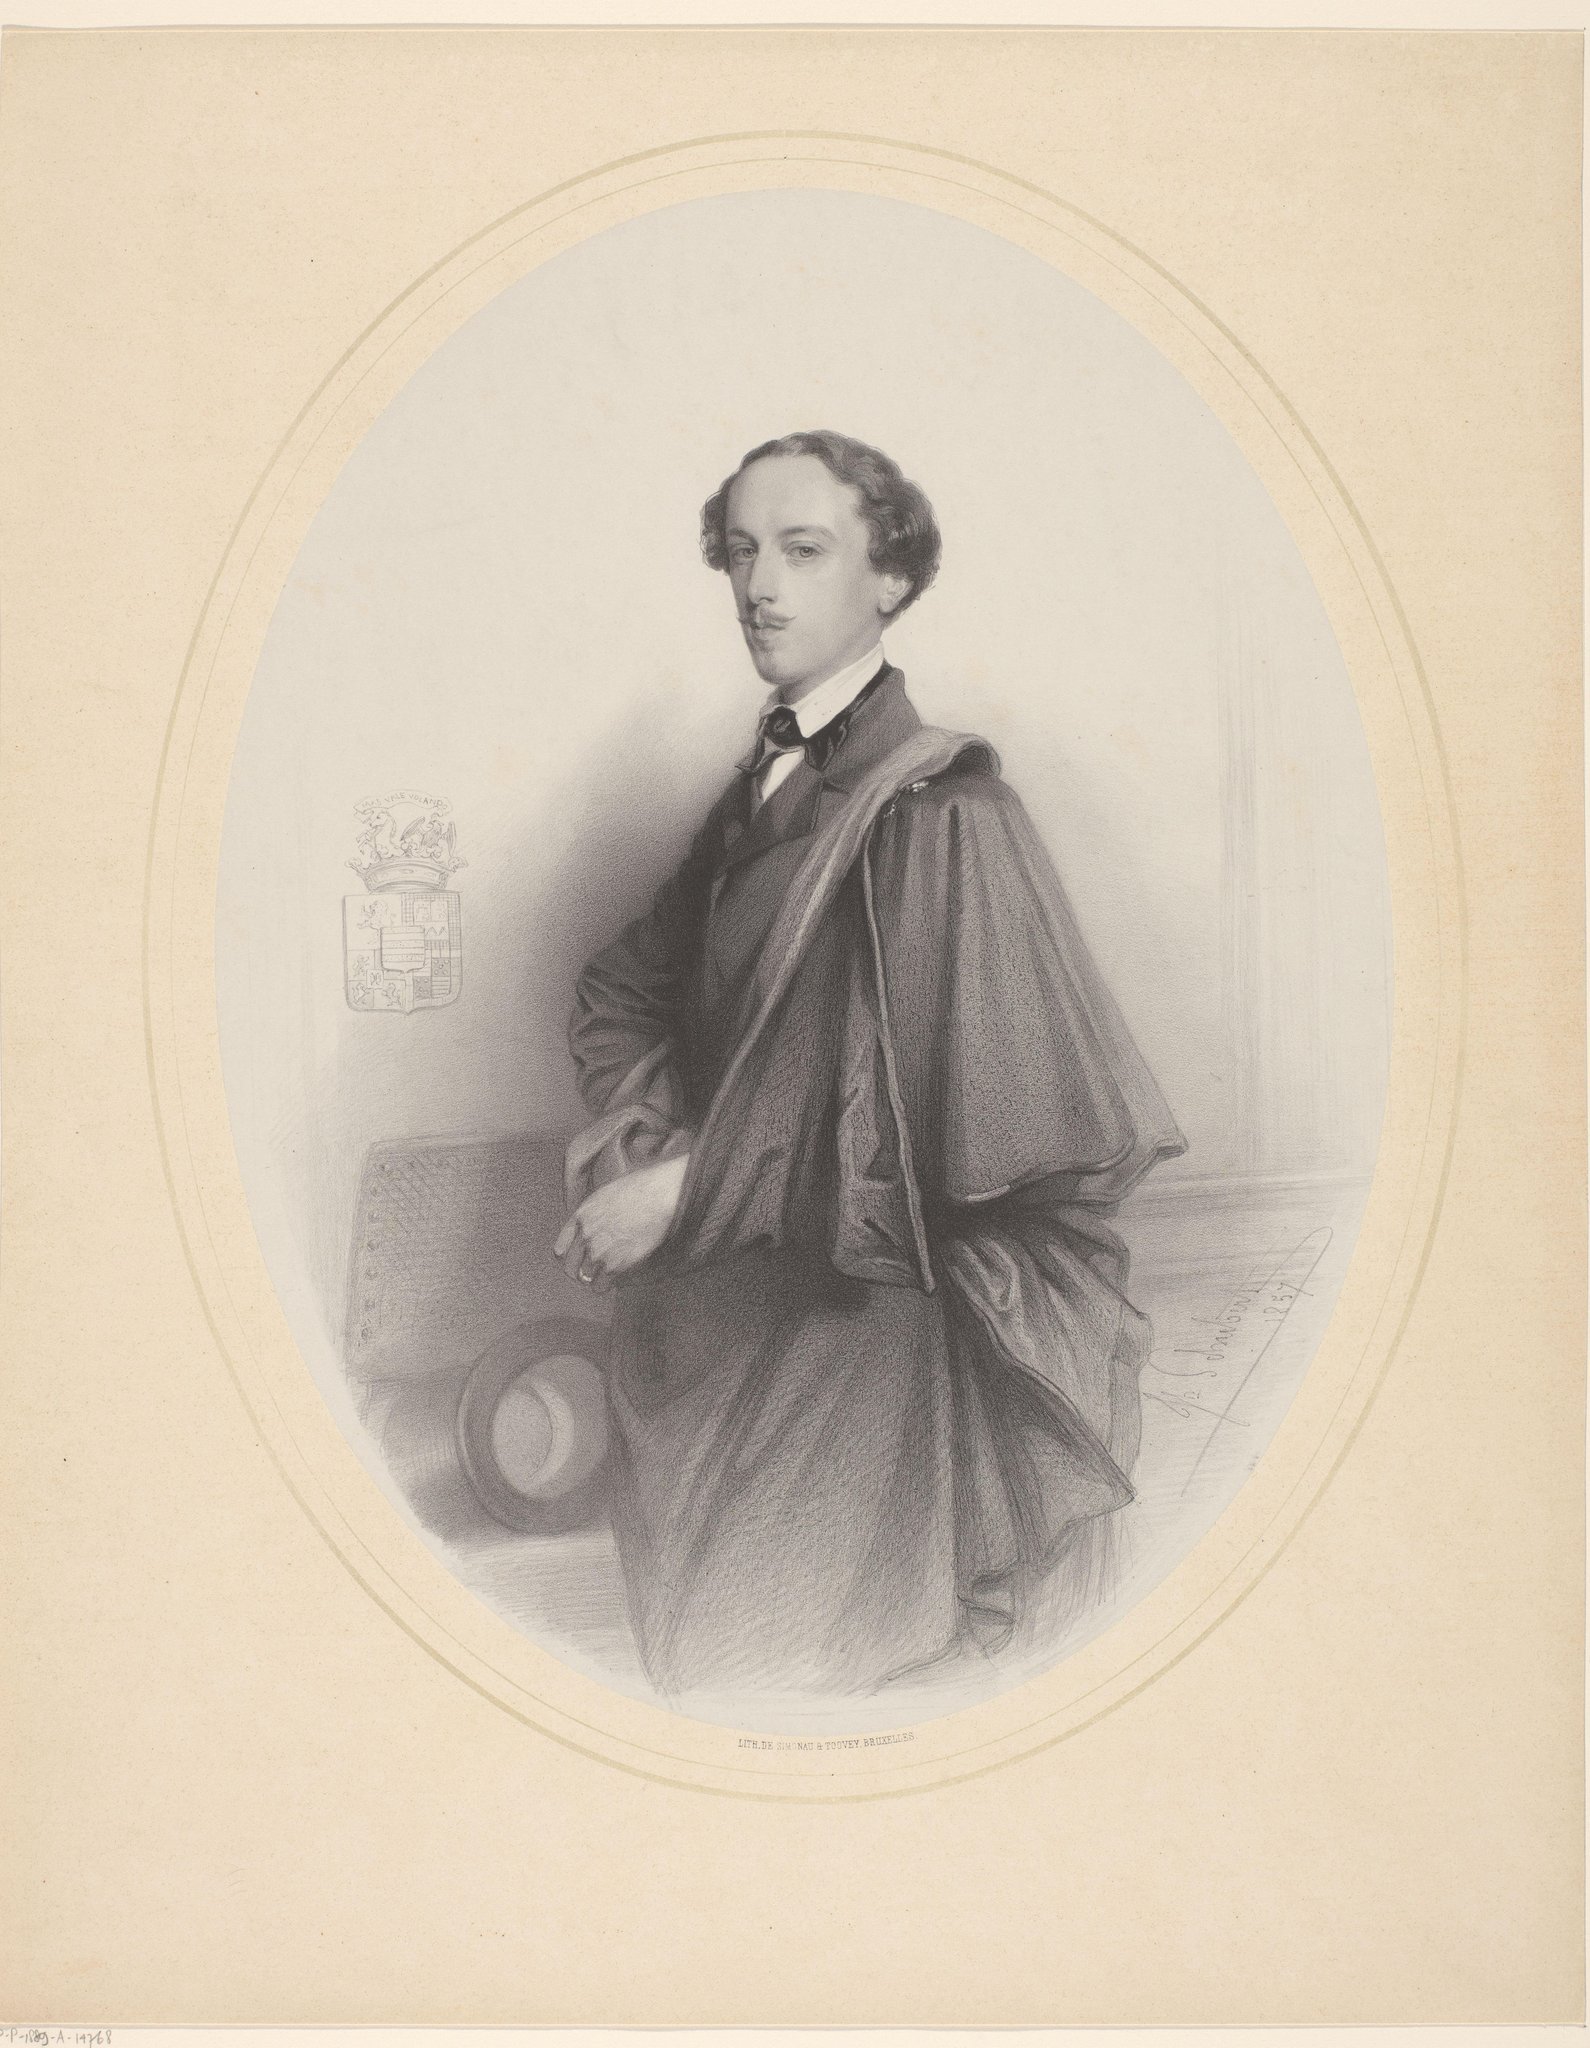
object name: print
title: Portret van een onbekende man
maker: joseph schubert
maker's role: print maker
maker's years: 1816-1885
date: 1857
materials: paper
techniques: tone lithography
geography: brussels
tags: historical persons not known by name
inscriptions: collector's mark: Lugt 2228